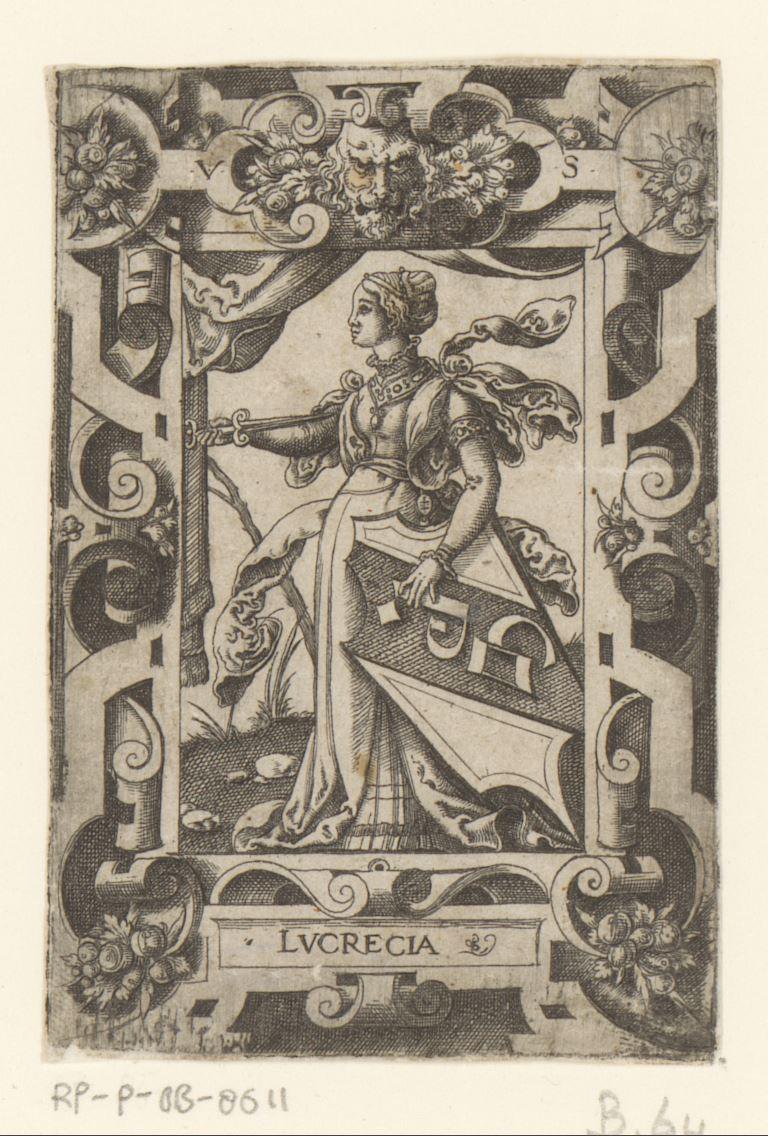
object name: print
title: Lucretia met wapenschild in rolwerk omlijsting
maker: virgilius solis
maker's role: draughtsman, print maker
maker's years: 1514-1562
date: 1524-1562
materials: paper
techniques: engraving, etching, intaglio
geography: nuremberg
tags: lucretia (one of the nine worthiest women)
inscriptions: number: ‘64’, collector's mark: Lugt 2228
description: Deze prent maakt deel uit van een serie bestaande uit negen prenten van de vrouwelijke Negen Besten in rolwerk omlijstingen.